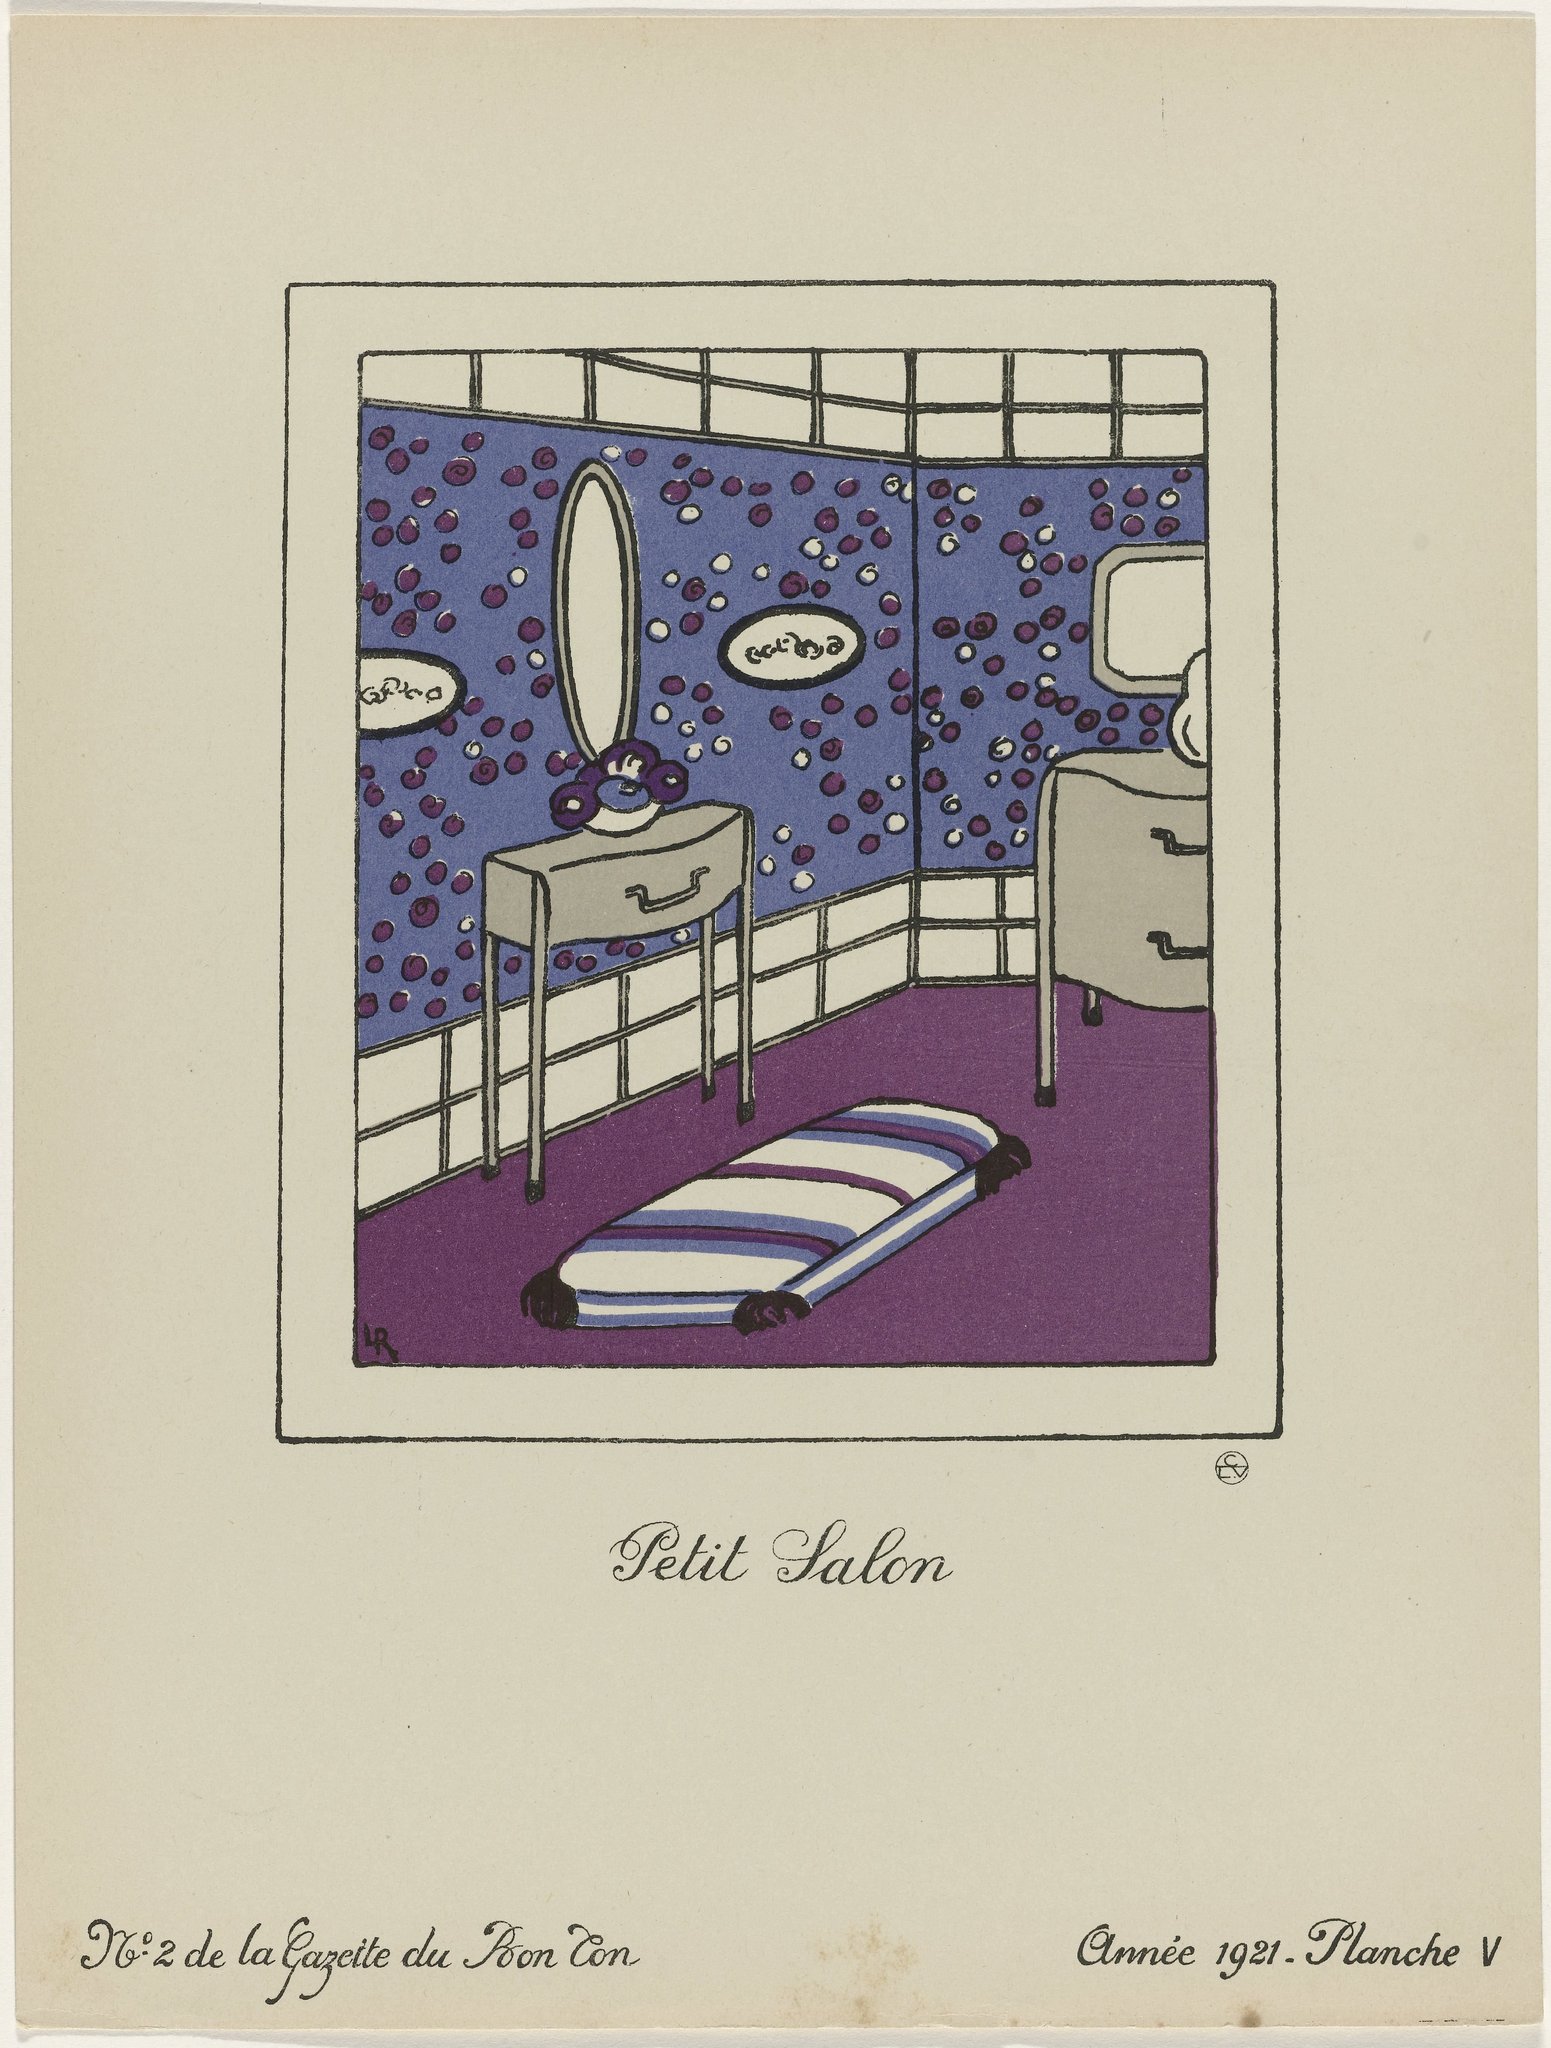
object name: fashion print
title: Furnishings and Interiors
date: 1921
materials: paper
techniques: lithograph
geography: new york city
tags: drawing-room, 'salon', furniture for storage, mirror, fashion plates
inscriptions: date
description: The very first fashion magazine, the Cabinet des Modes (1785-1797), had occasionally also published pictures of new furniture or an interior to alternate with the fashions. The Gazette du Bon Ton picked up this tradition, enabling interior decorators and furniture designers to spread their ideas too. Some editions came with supplements consisting of an insert of four or five croquis (sketches) depicting modern interiors: